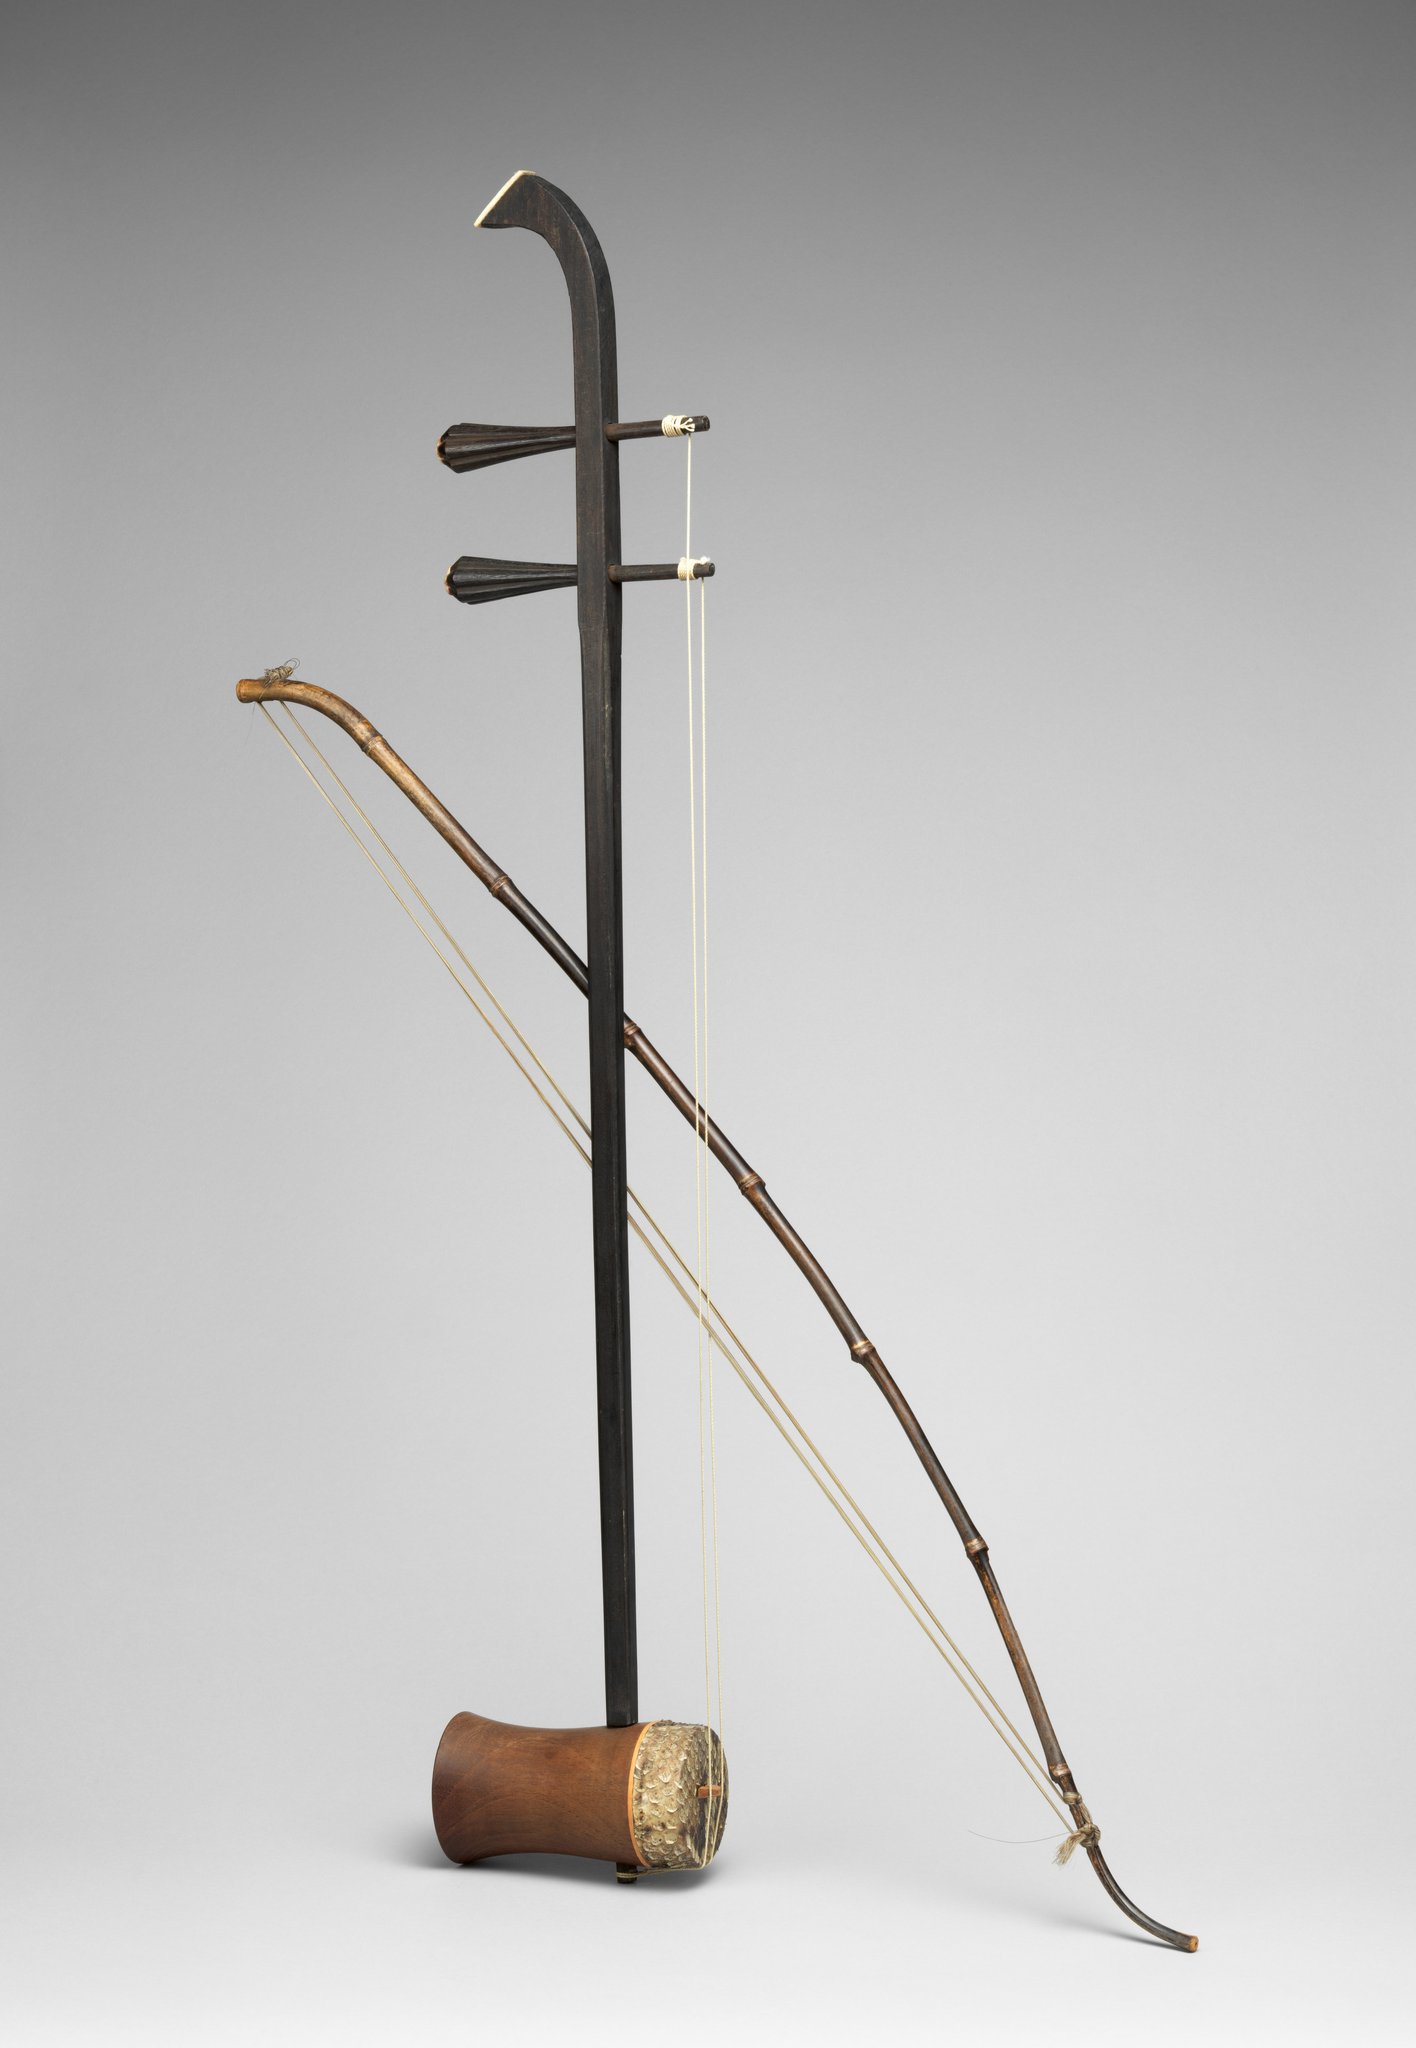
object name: erhu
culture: chinese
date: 1801-1900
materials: ivory, skin, wood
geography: china